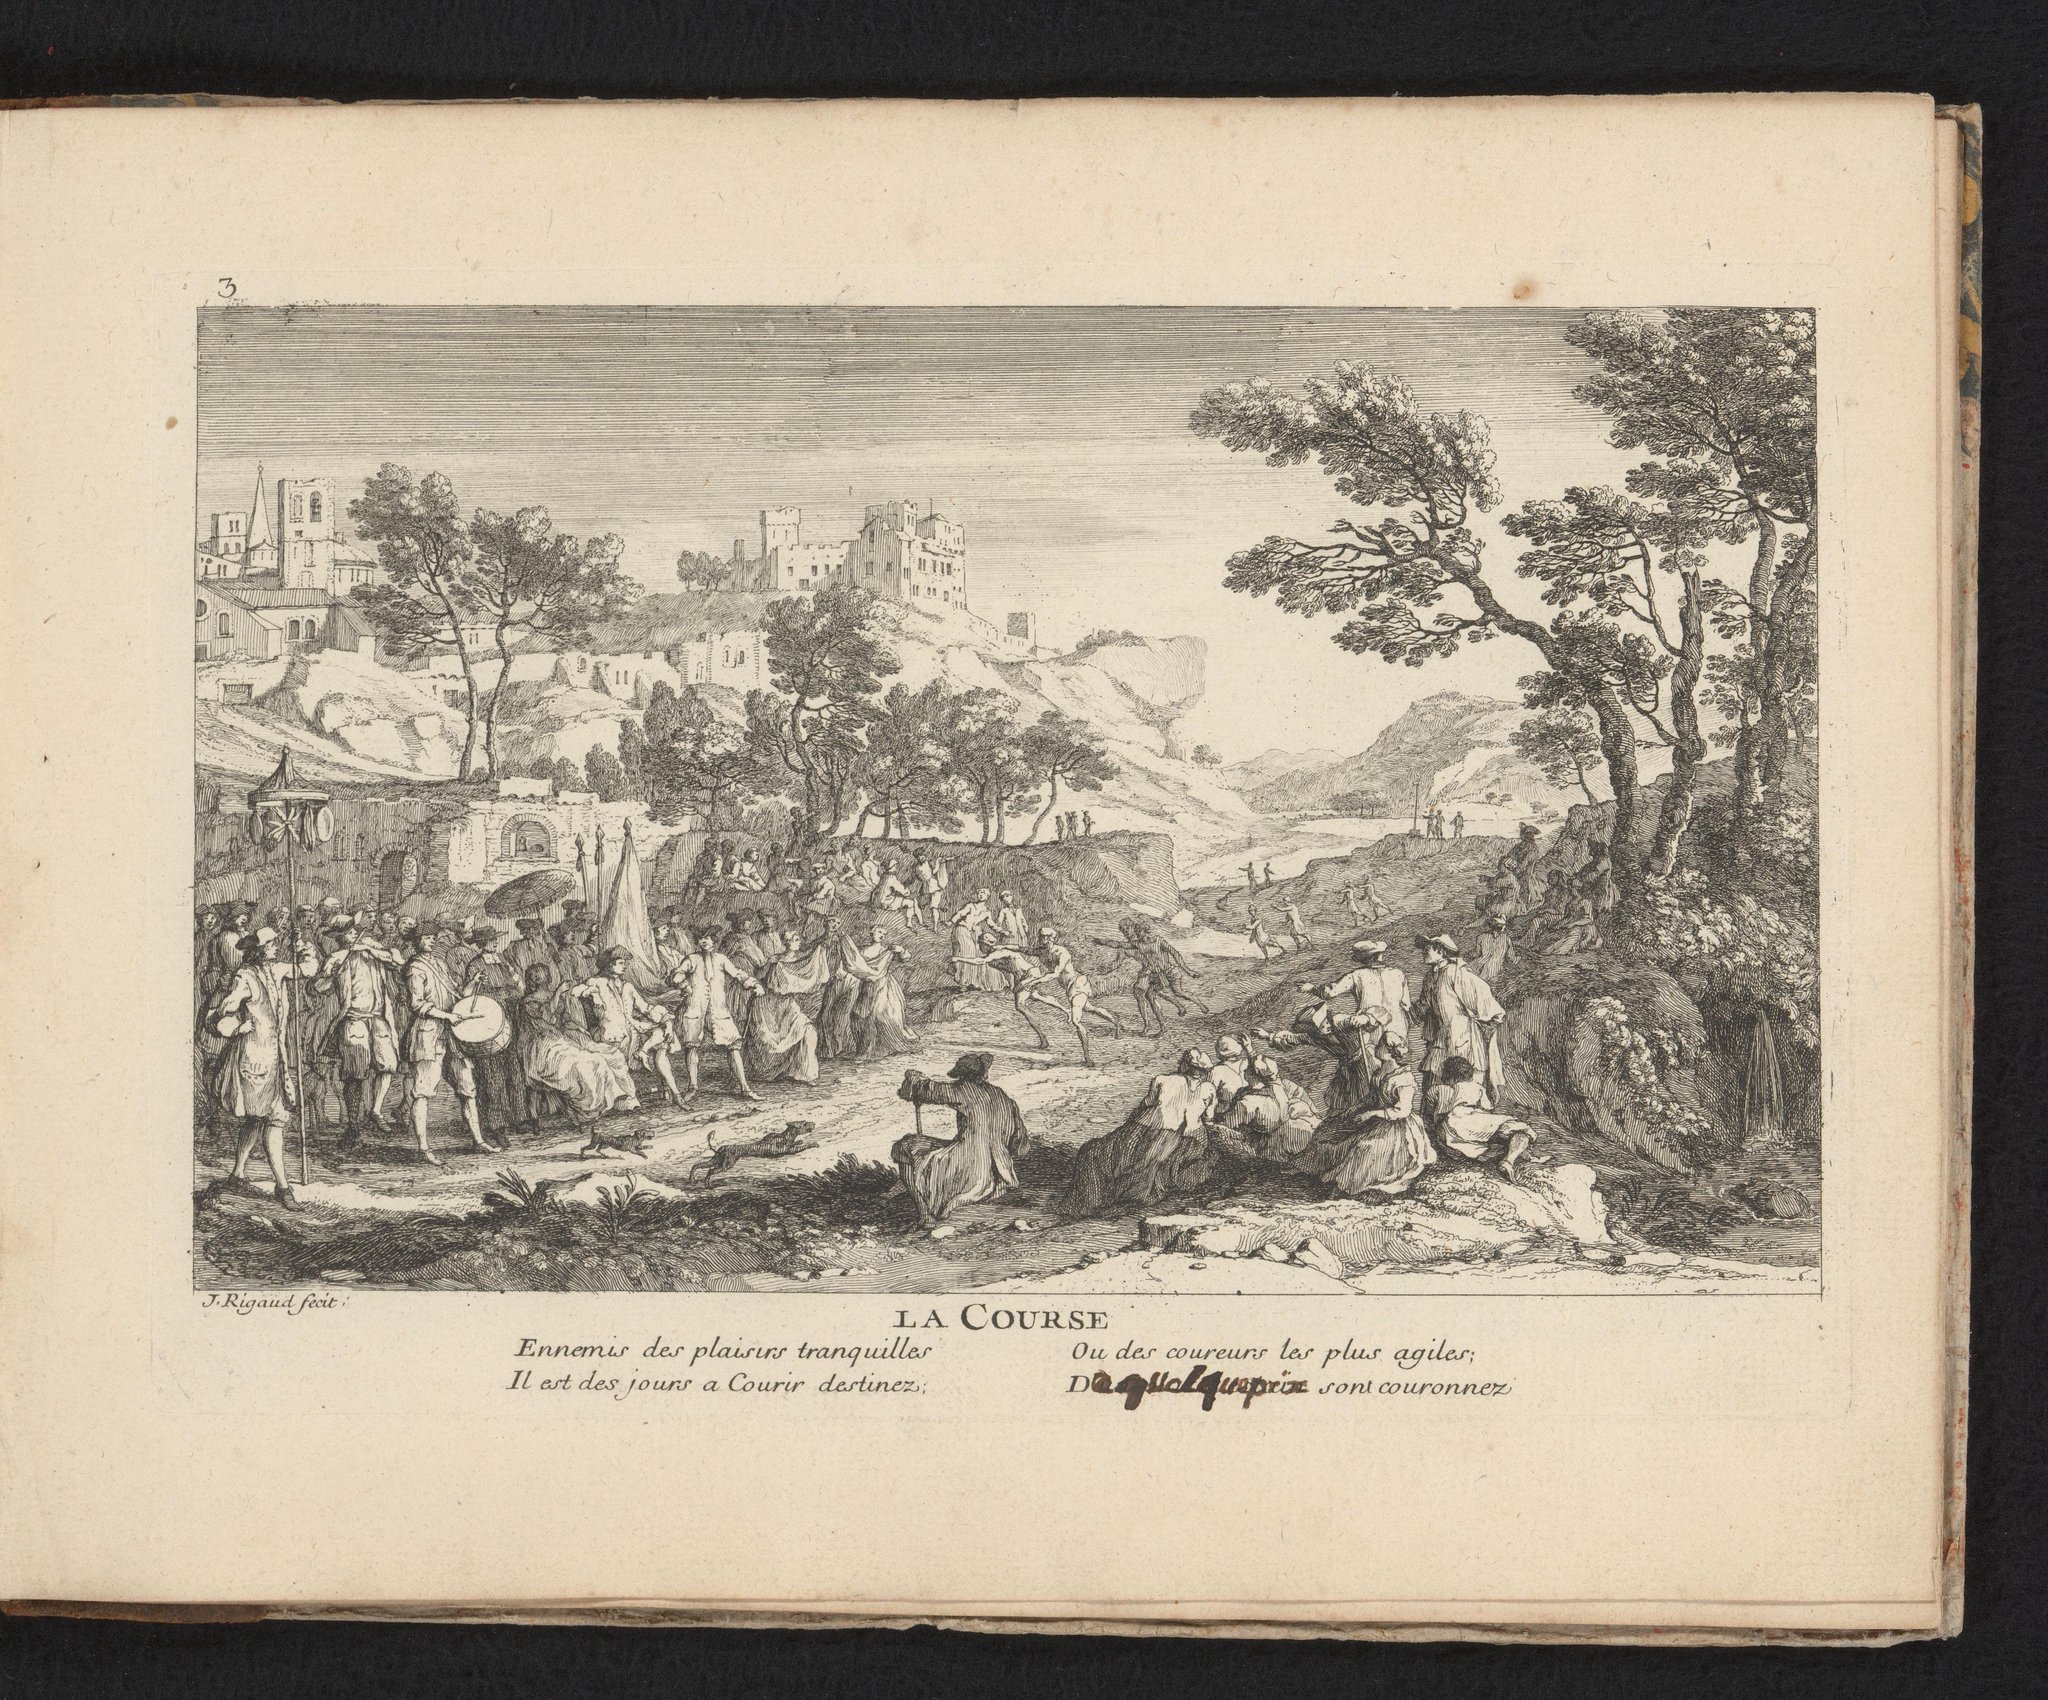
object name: album leaf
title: Provence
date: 1700-1725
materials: paper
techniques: etching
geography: paris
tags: running, race, running, sports, games and physical performances (+ public (sports, games, etc.))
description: Deze prent maakt deel uit van een album.